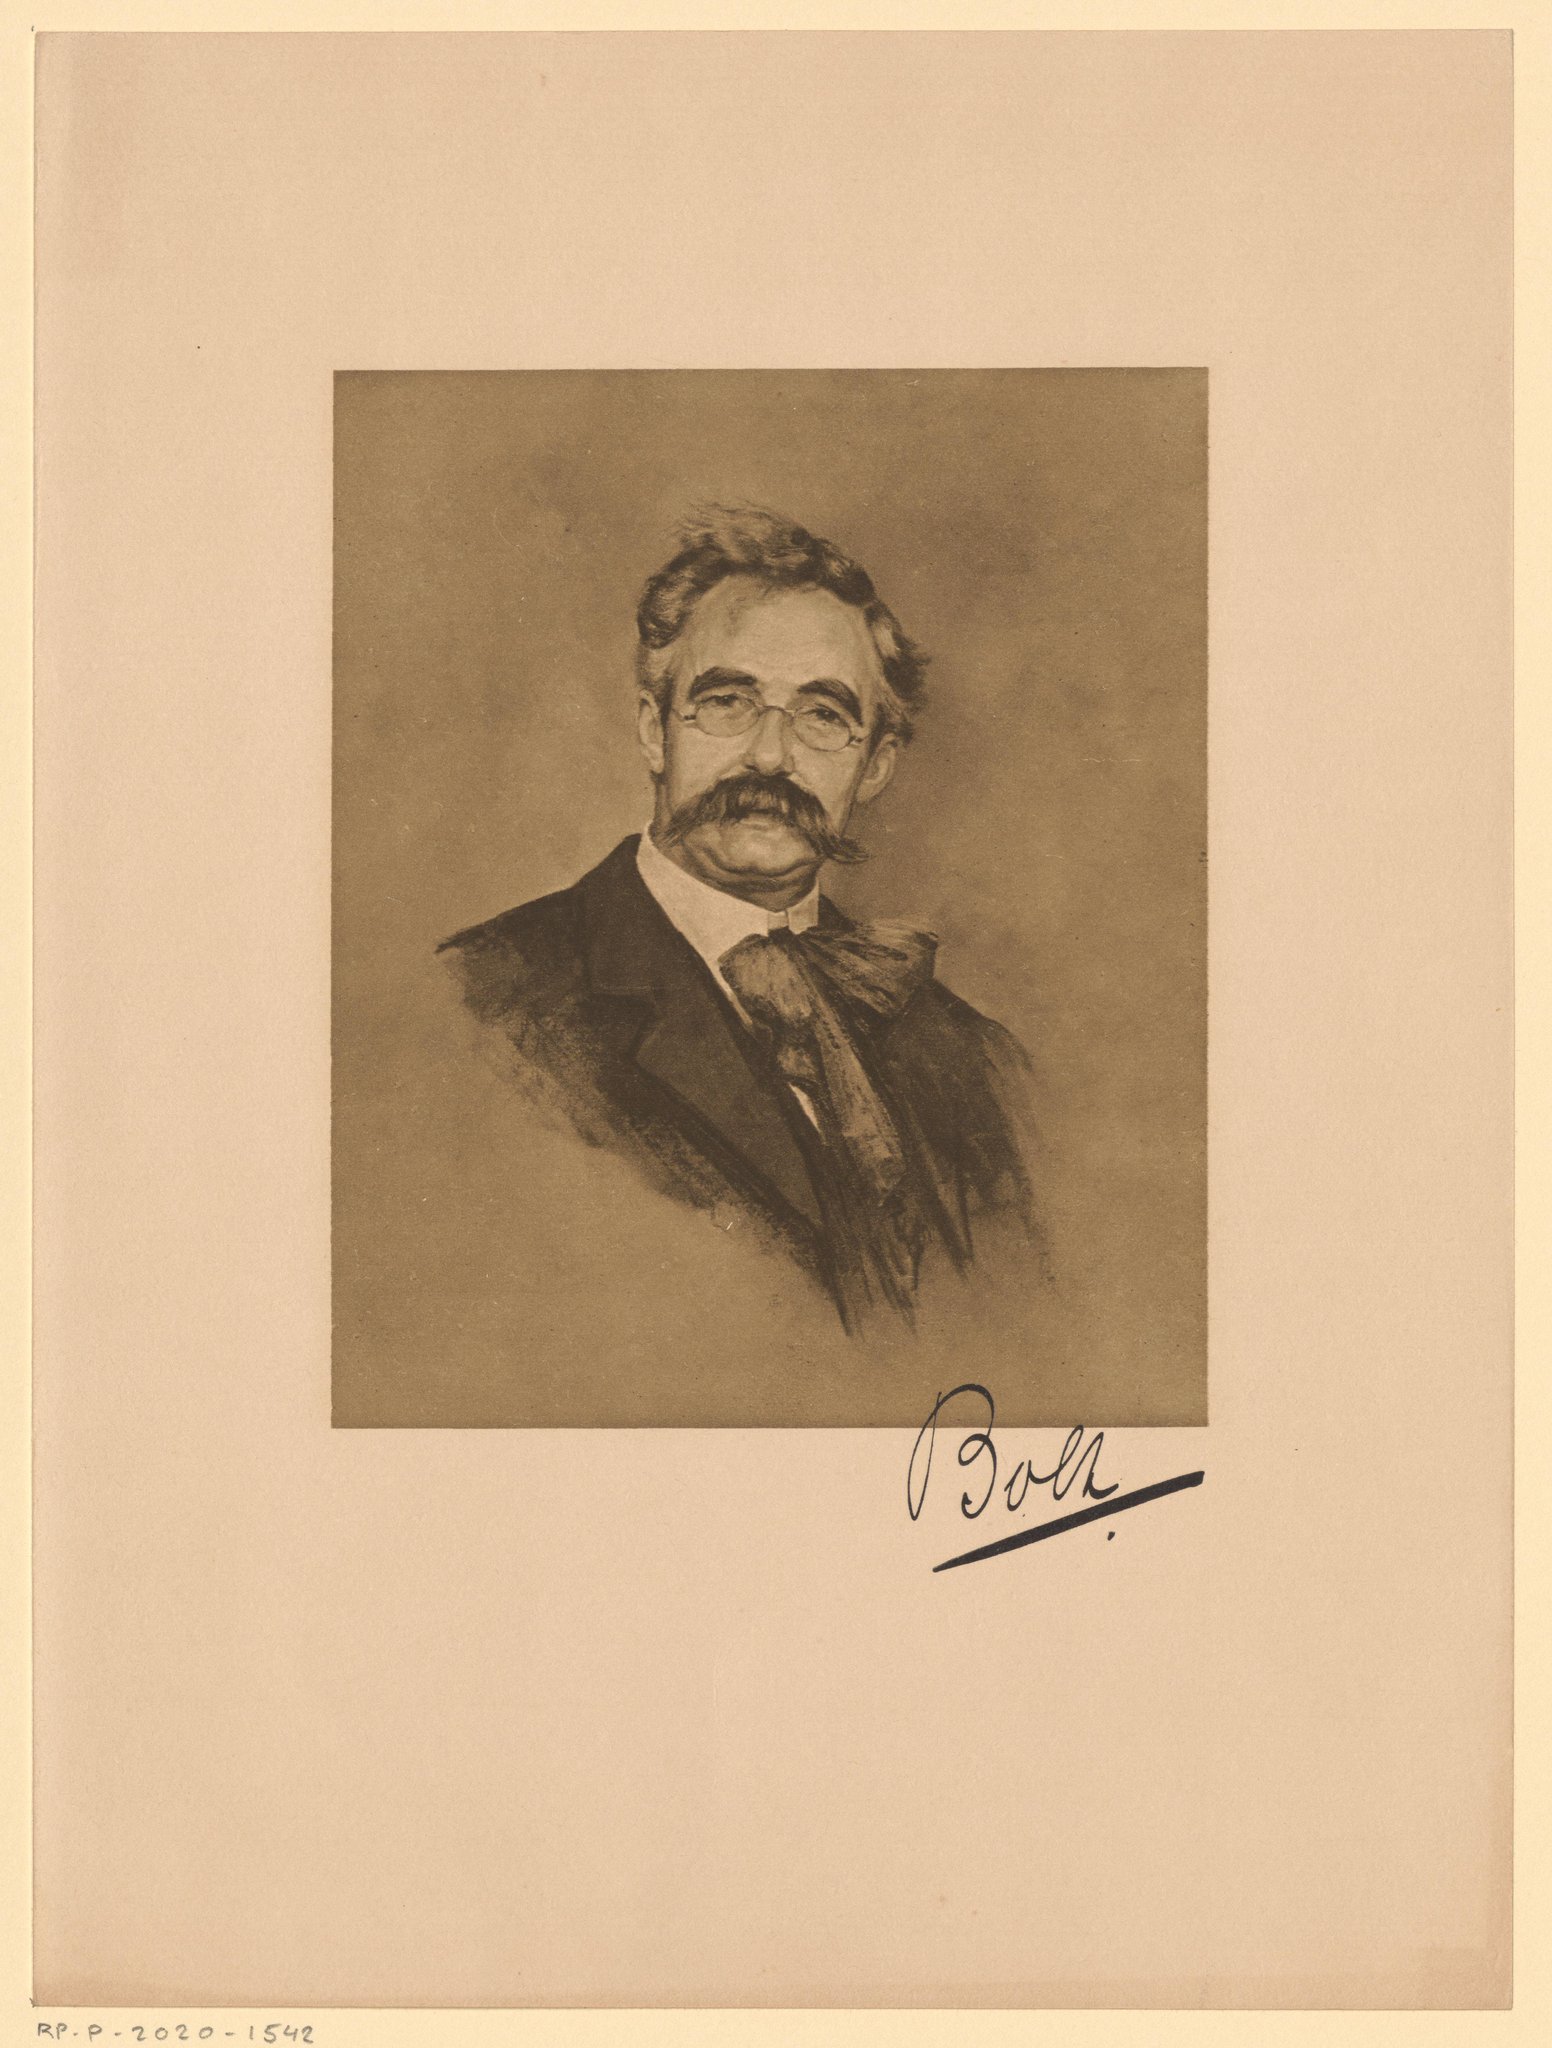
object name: photomechanical print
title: Portret van Lodewijk Bolk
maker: Anonymous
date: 1920-1940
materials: paper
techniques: rotogravure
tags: overschie, amsterdam, historical persons, professor